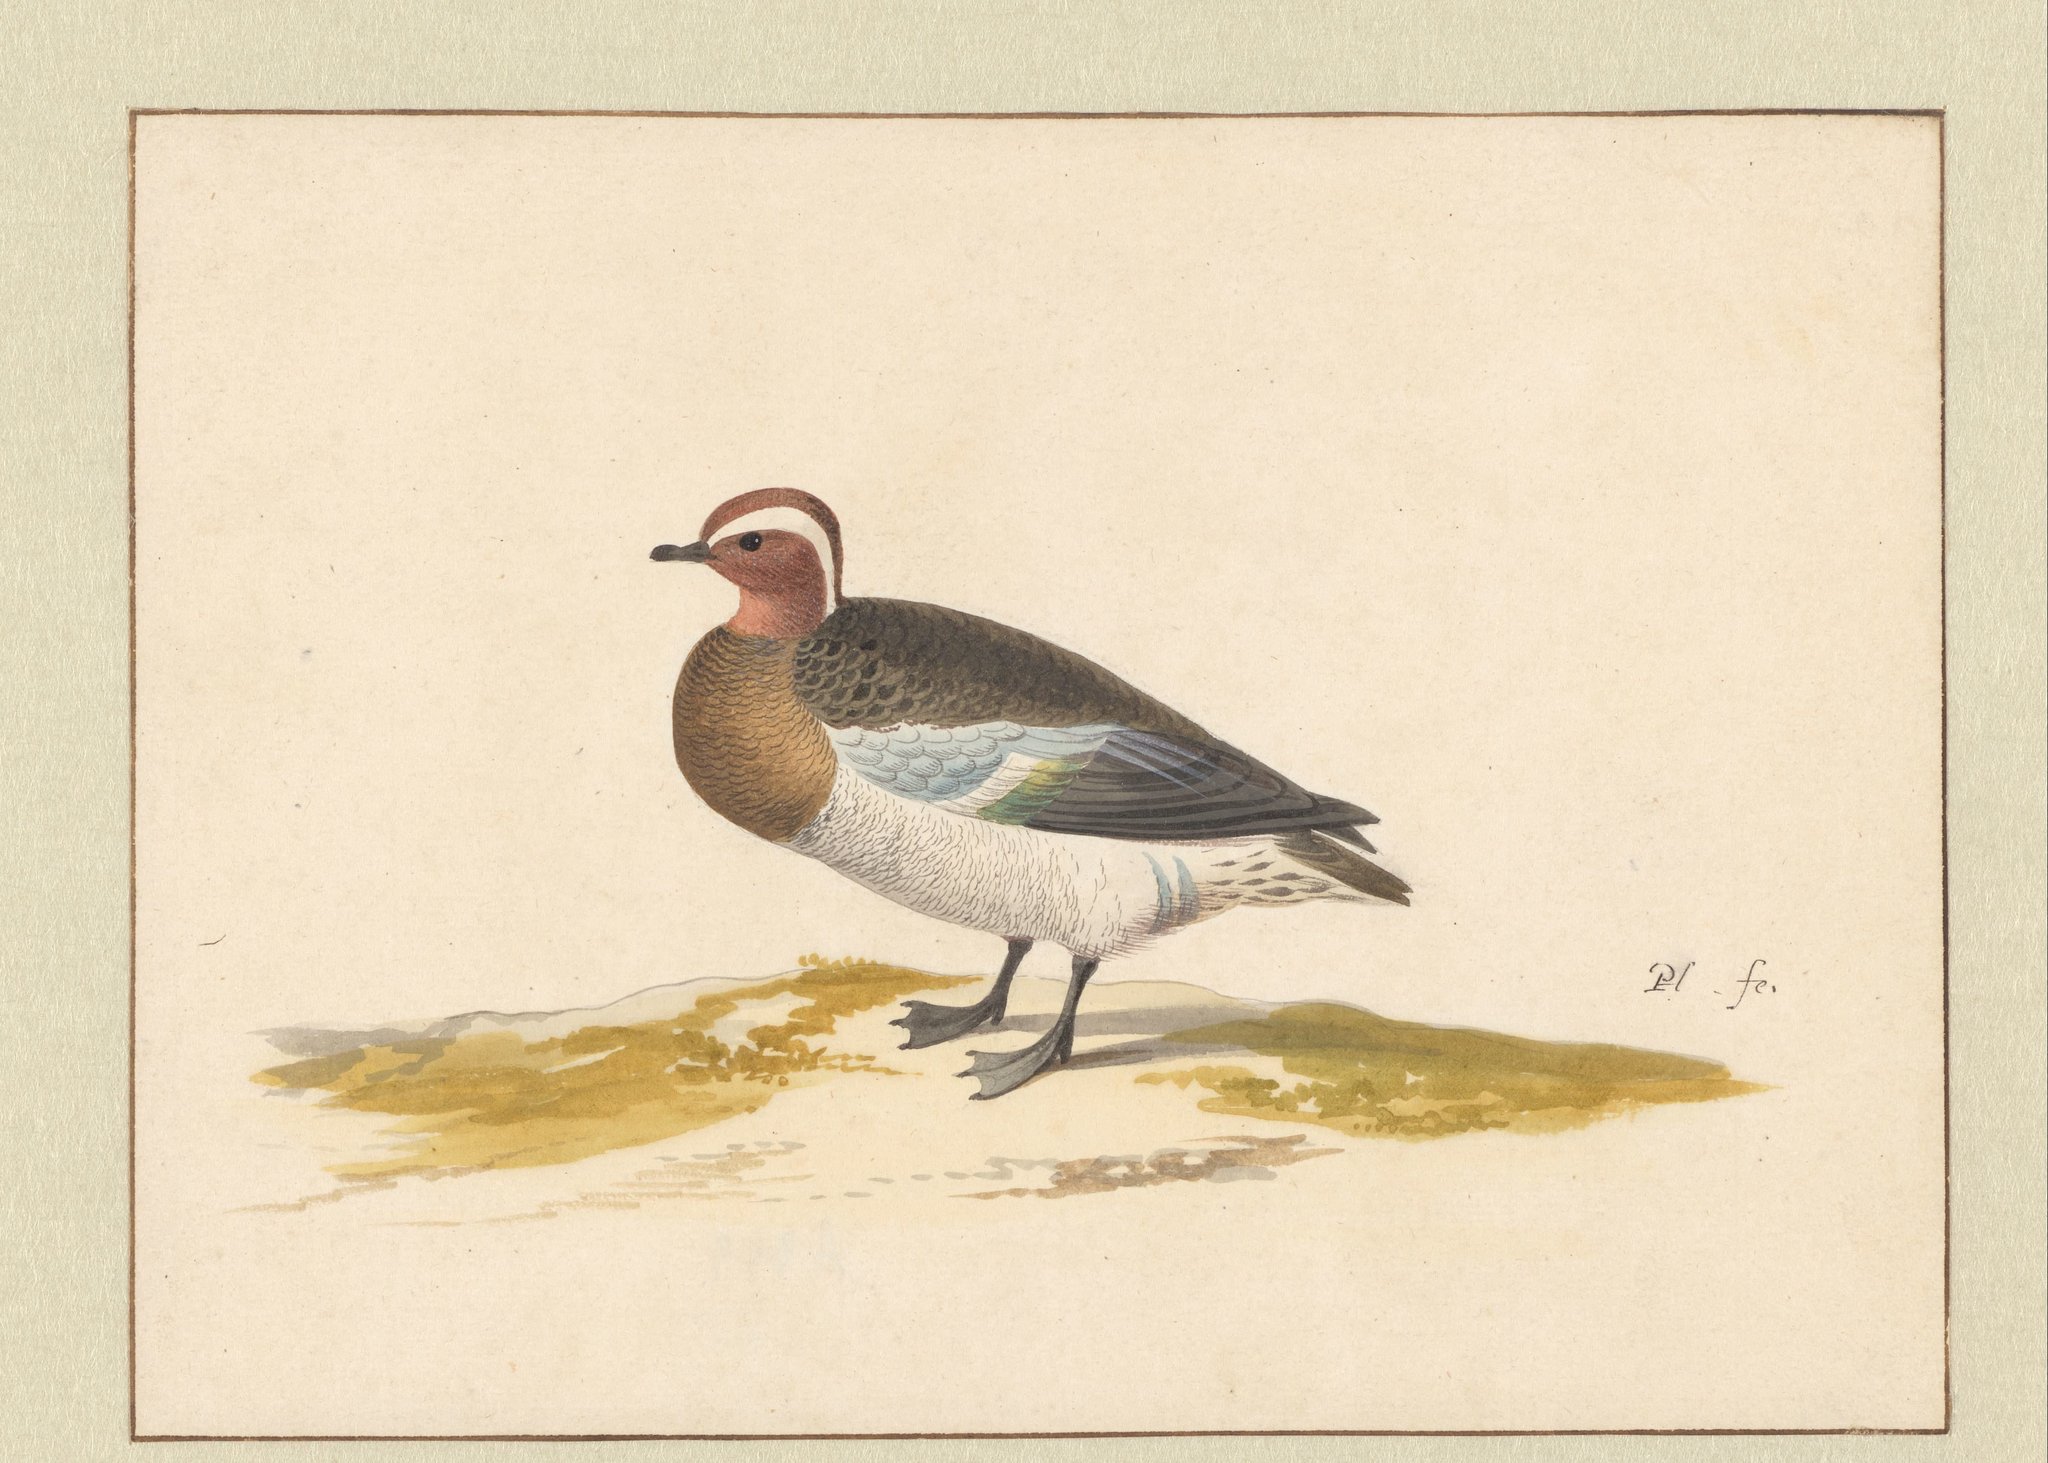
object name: drawing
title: Zomertaling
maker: pieter holsteyn (i)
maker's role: draughtsman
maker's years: 1580-1662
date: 1600-1662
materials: gouache, paper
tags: water-birds: teal